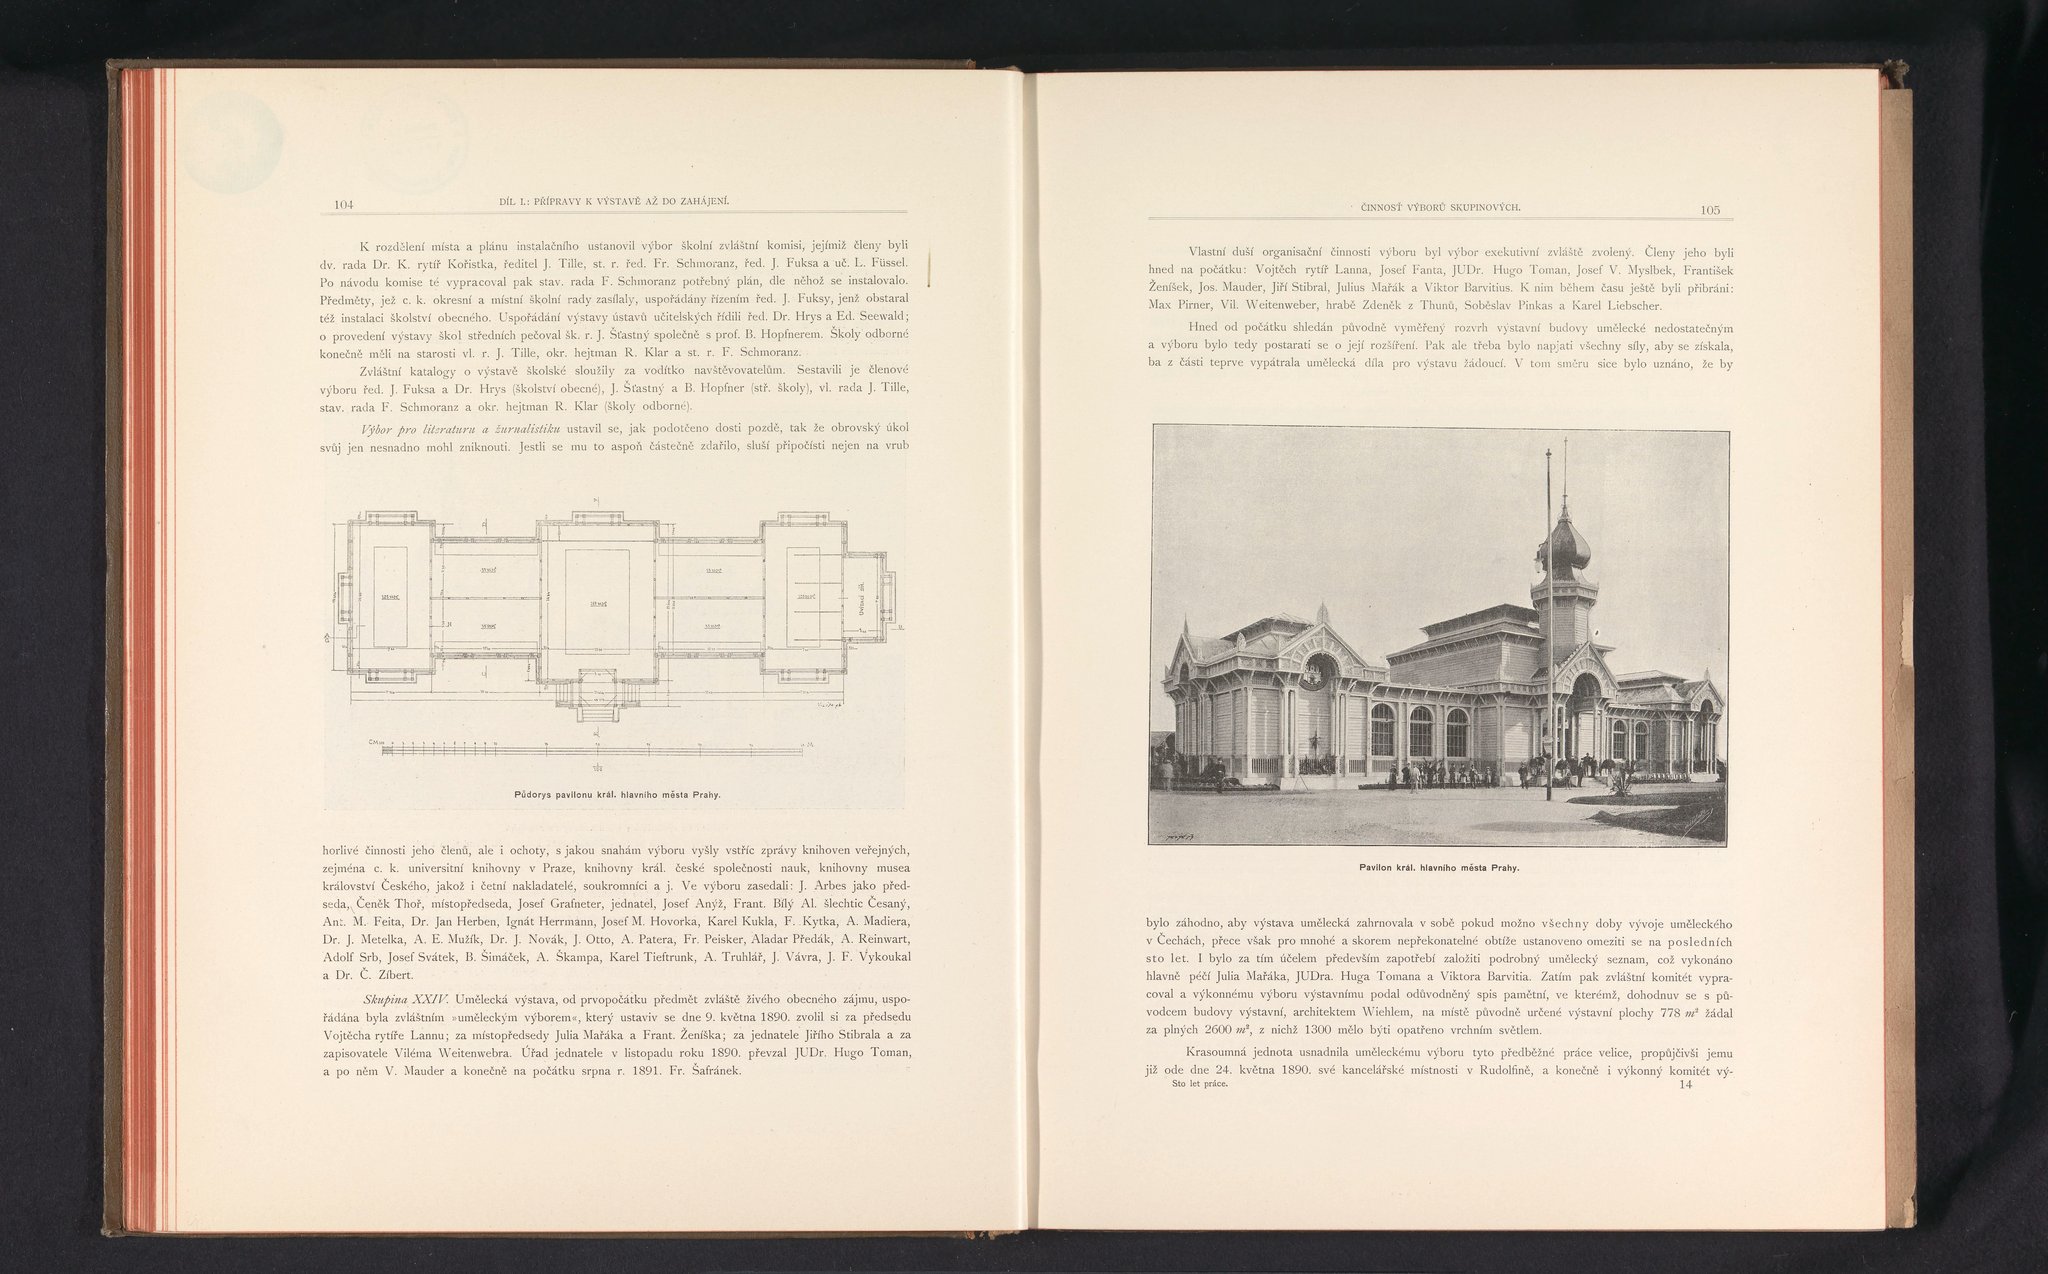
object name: page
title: Exterieur van het koninklijk paviljoen op het Výstaviště te Praag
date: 1888-1893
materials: paper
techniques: autotype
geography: výstaviště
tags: façade (of house or building), temporary exhibition, 'salon'